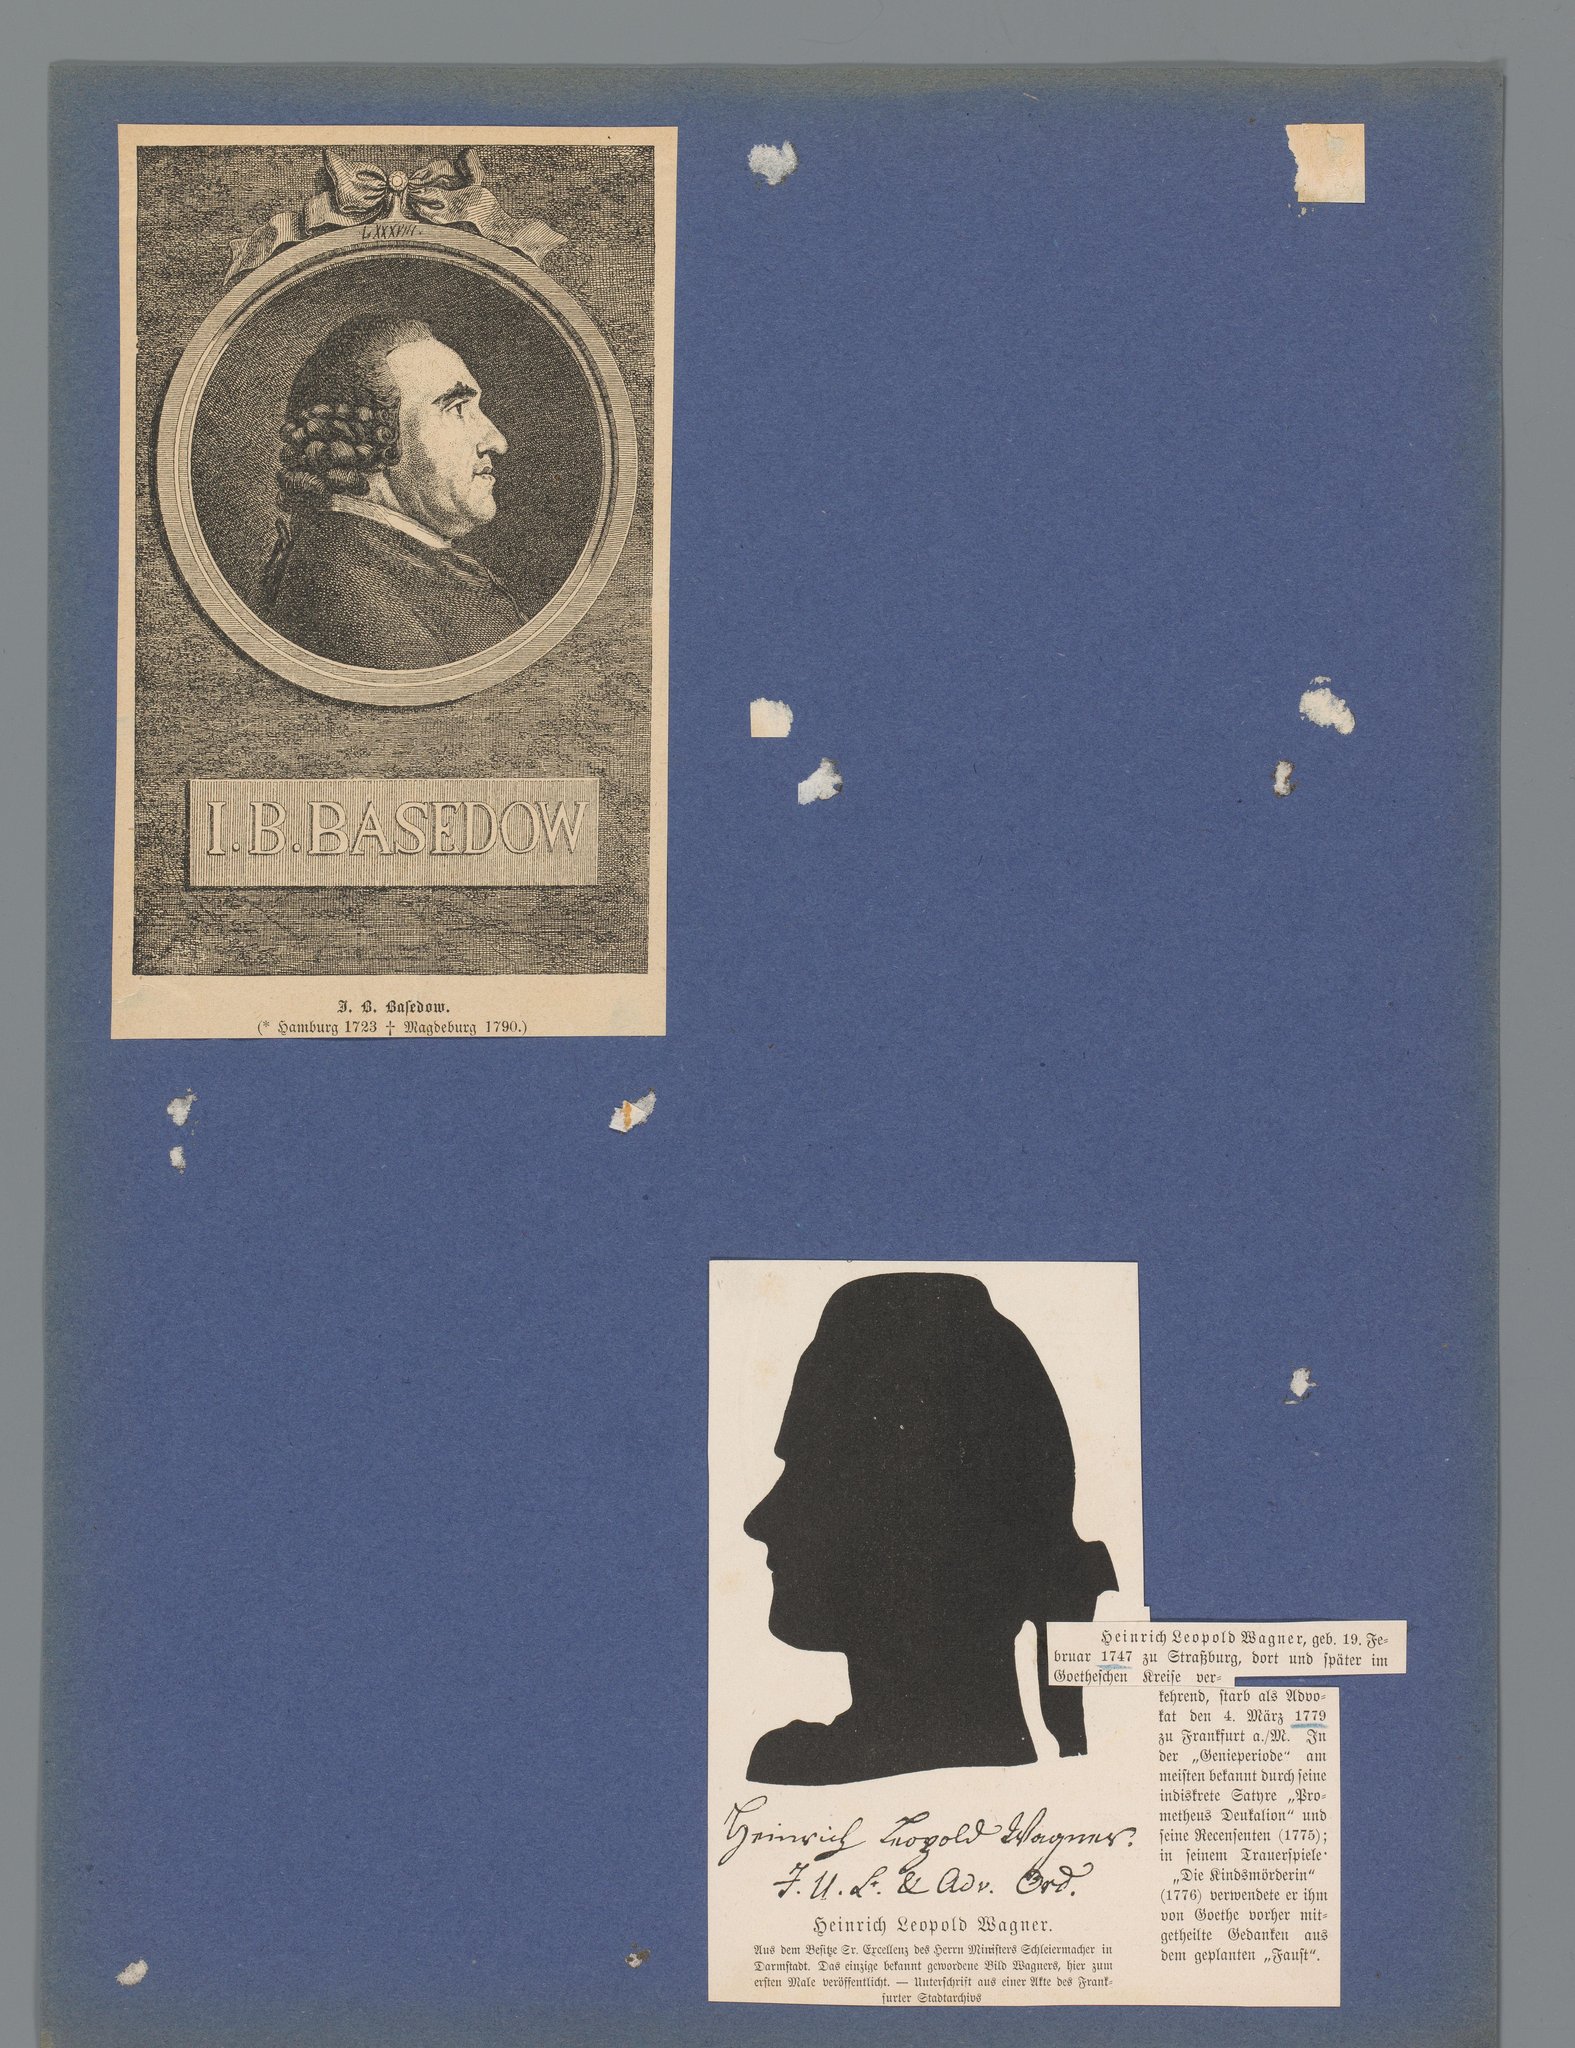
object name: print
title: Blad met één portret van Johann Bernhard Basedow en één van Heinrich Leopold Wagner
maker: Anonymous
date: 1850-1900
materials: paper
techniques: snipping, engraving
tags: johann bernhard basedow, historical persons, portrait of a writer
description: Met facsimile handtekening van Heinrich Leopold Wagner.